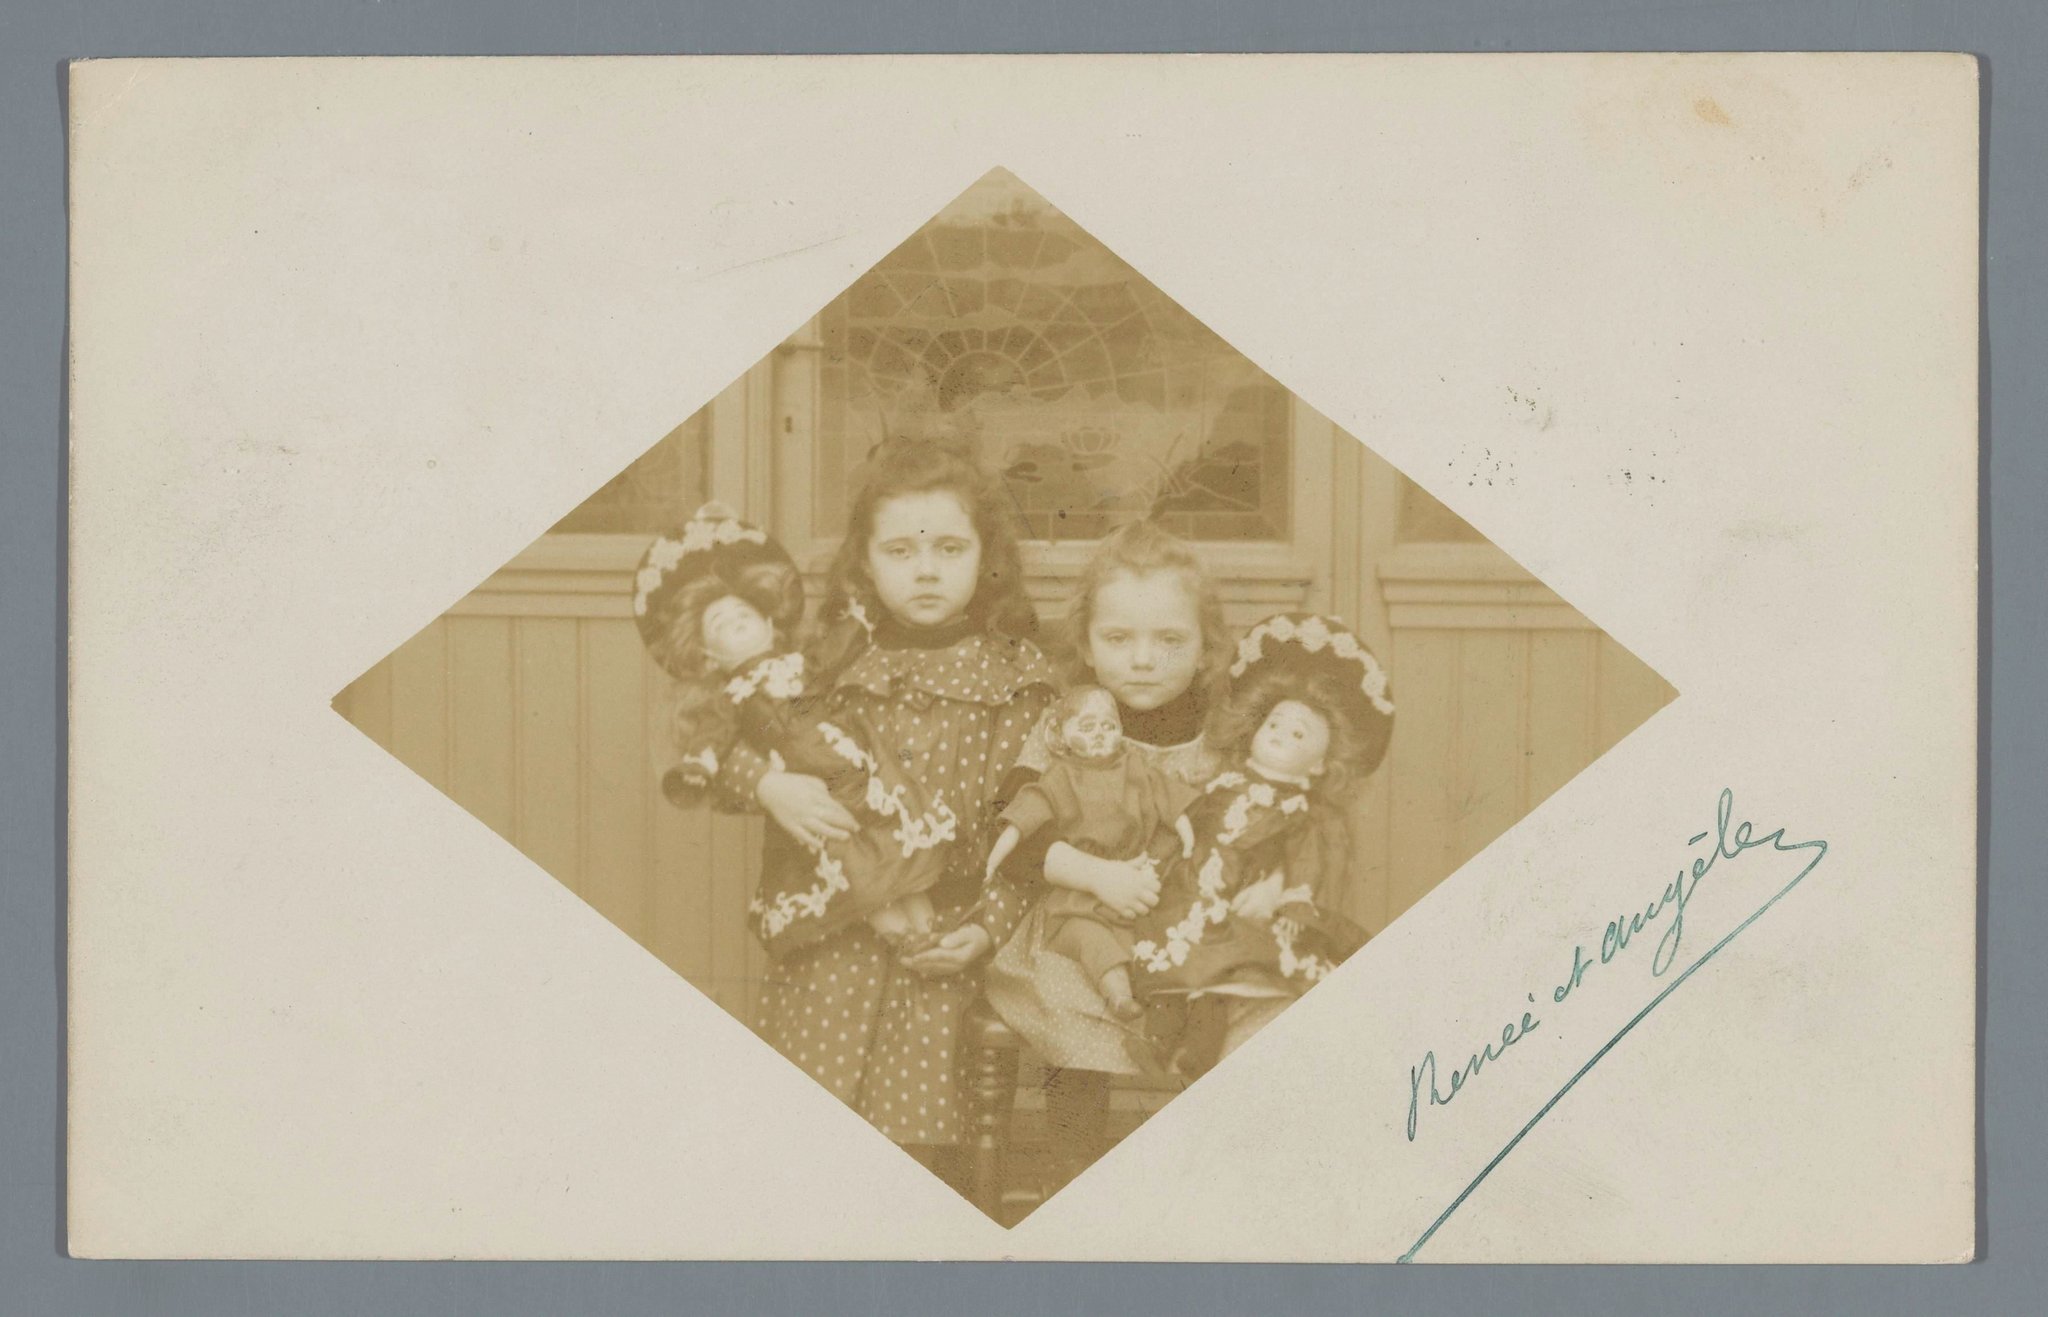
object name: ansichtkaart, prentbriefkaart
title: Kinderportret van Renée en Angèle met poppen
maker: Anonymous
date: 1908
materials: photographic support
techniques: gelatin silver print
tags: girl (child between toddler and youth), (playing with) dolls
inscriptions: inscription: ‘Mademoiselle Georgette Smeysters 57 longue rue Ruysbroek Anvers Zurenborg’, inscription: ‘Renée et Angèle’